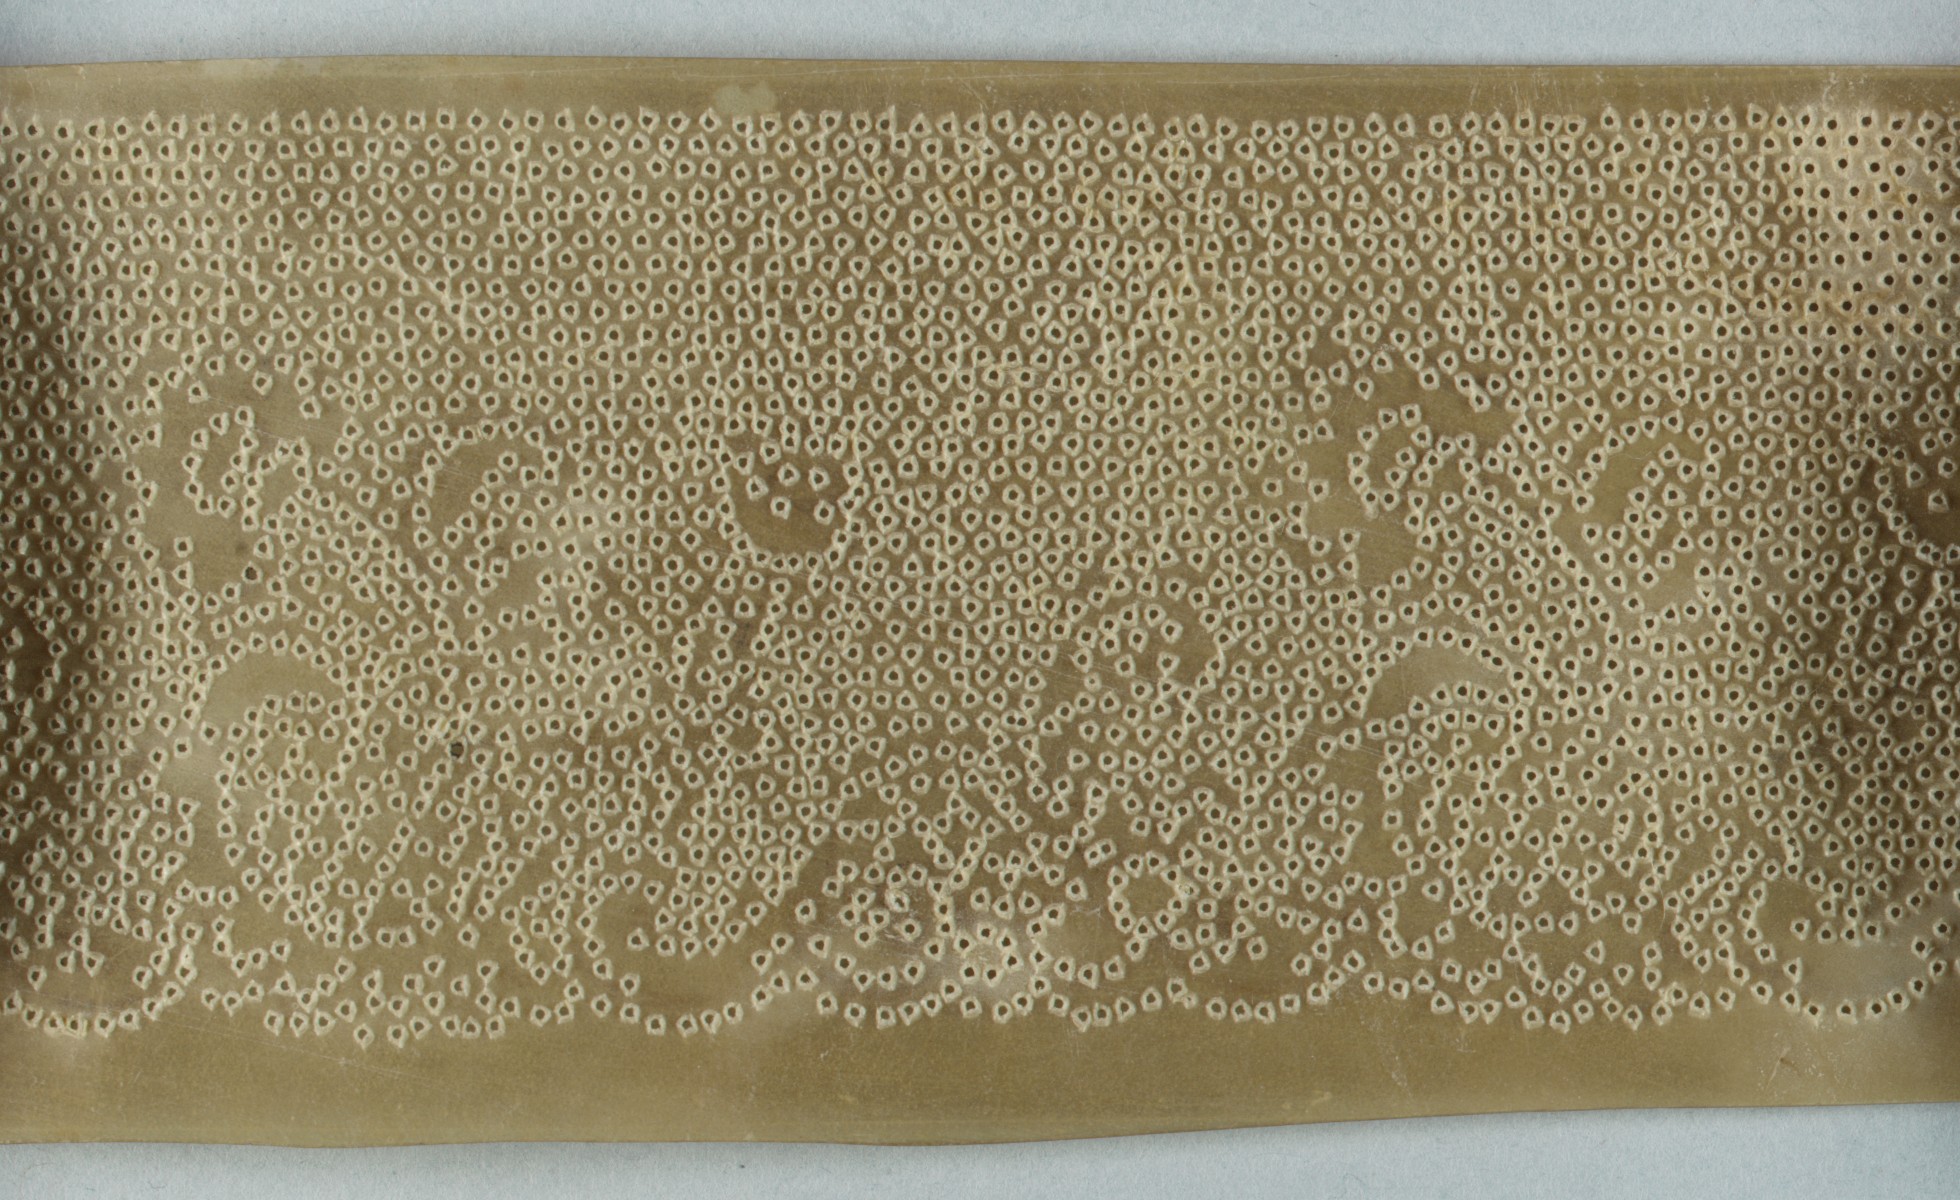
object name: pattern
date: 1840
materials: parchment